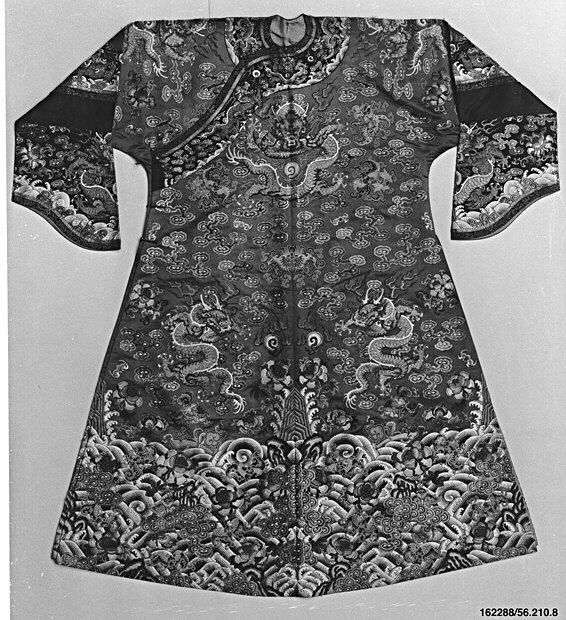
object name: robe, empress's long pao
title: Empress's Robe (Long Pao)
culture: chinese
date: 1801-1833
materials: silk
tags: dragons